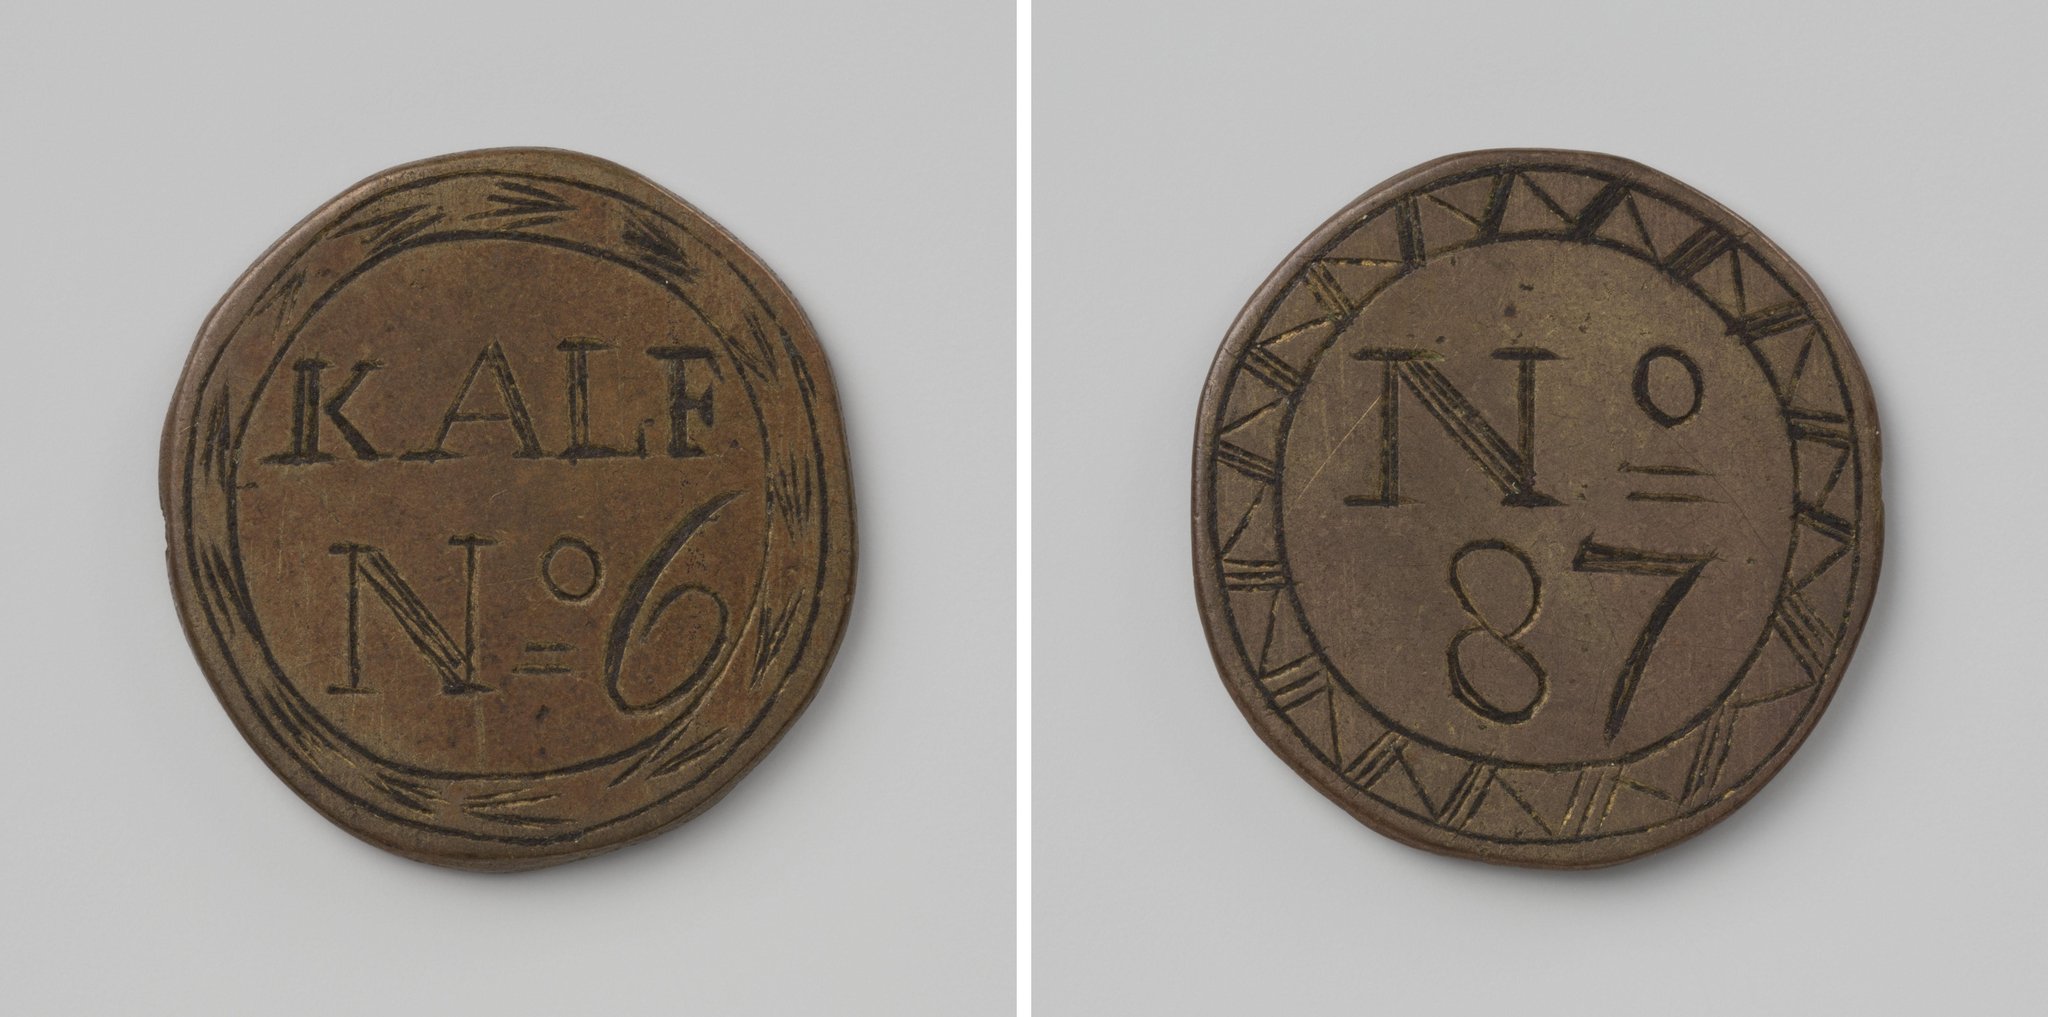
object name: fire engine medal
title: Kalf, brandspuitpenning van spuit 6 met no. 87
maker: Anonymous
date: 1680-1850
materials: brass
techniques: engraving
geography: netherlands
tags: kalf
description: Messing penning. Voorzijde: opschrift en cijfer No. 6 binnen bladerkrans. Keerzijde: cijfer No. 87 binnen krans van driehoeken